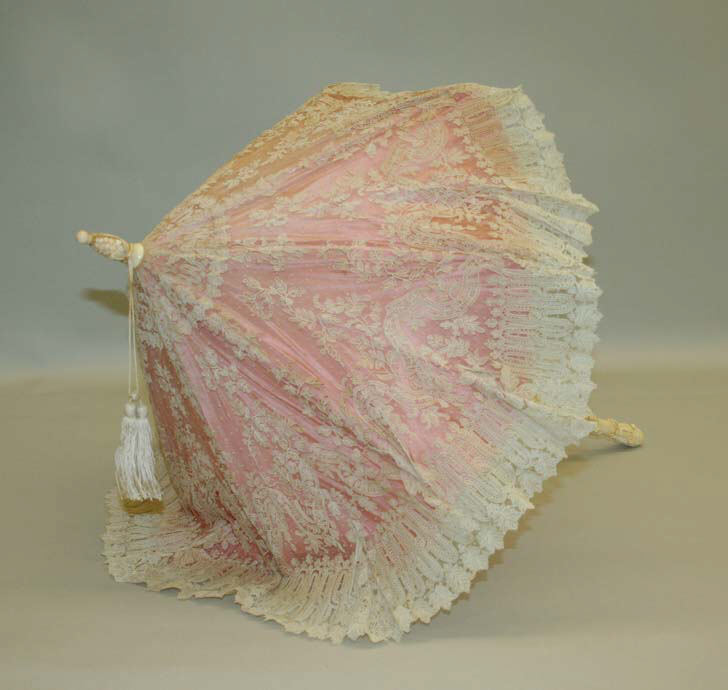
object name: parasol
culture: french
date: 1867-1900